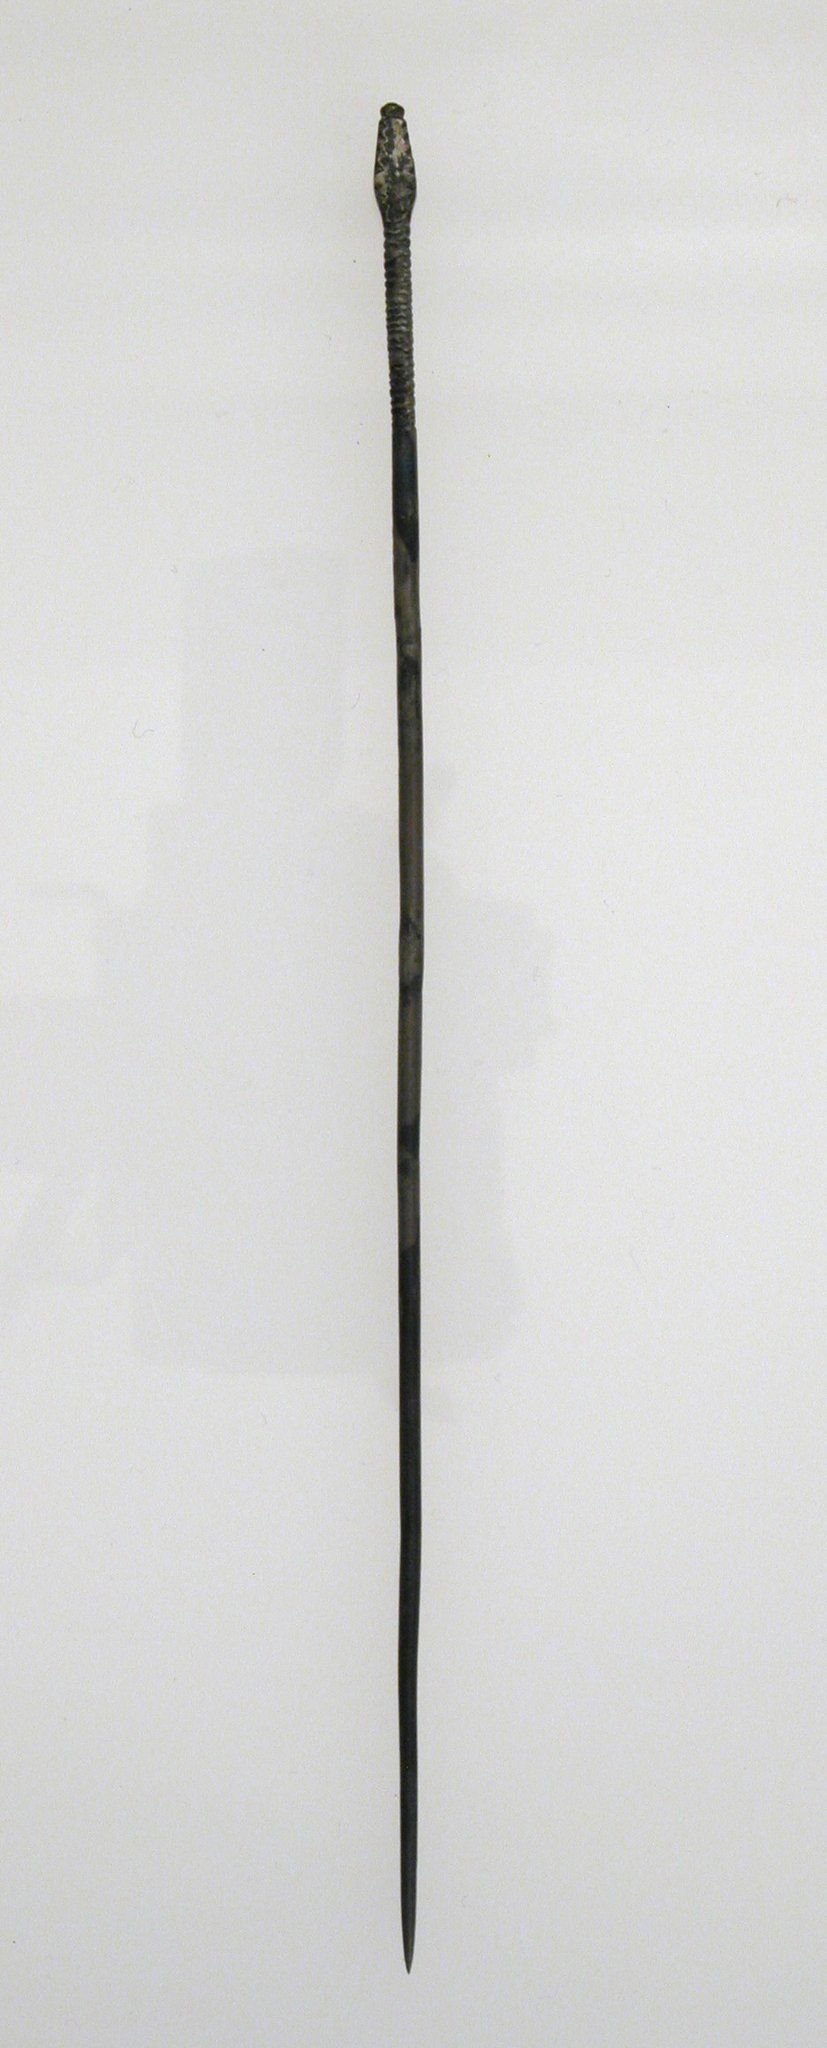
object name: hairpin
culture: frankish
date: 601-700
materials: silver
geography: northern france